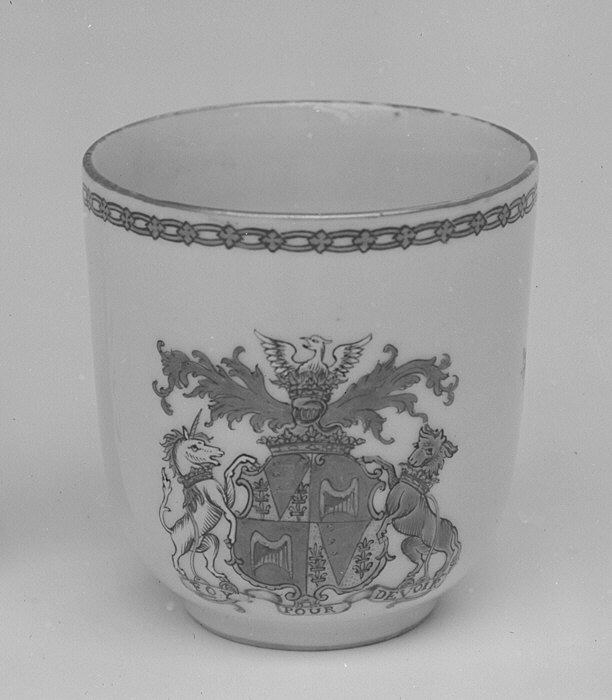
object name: cup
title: Cup (part of a service)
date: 1750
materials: hard paste porcelain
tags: coat of arms